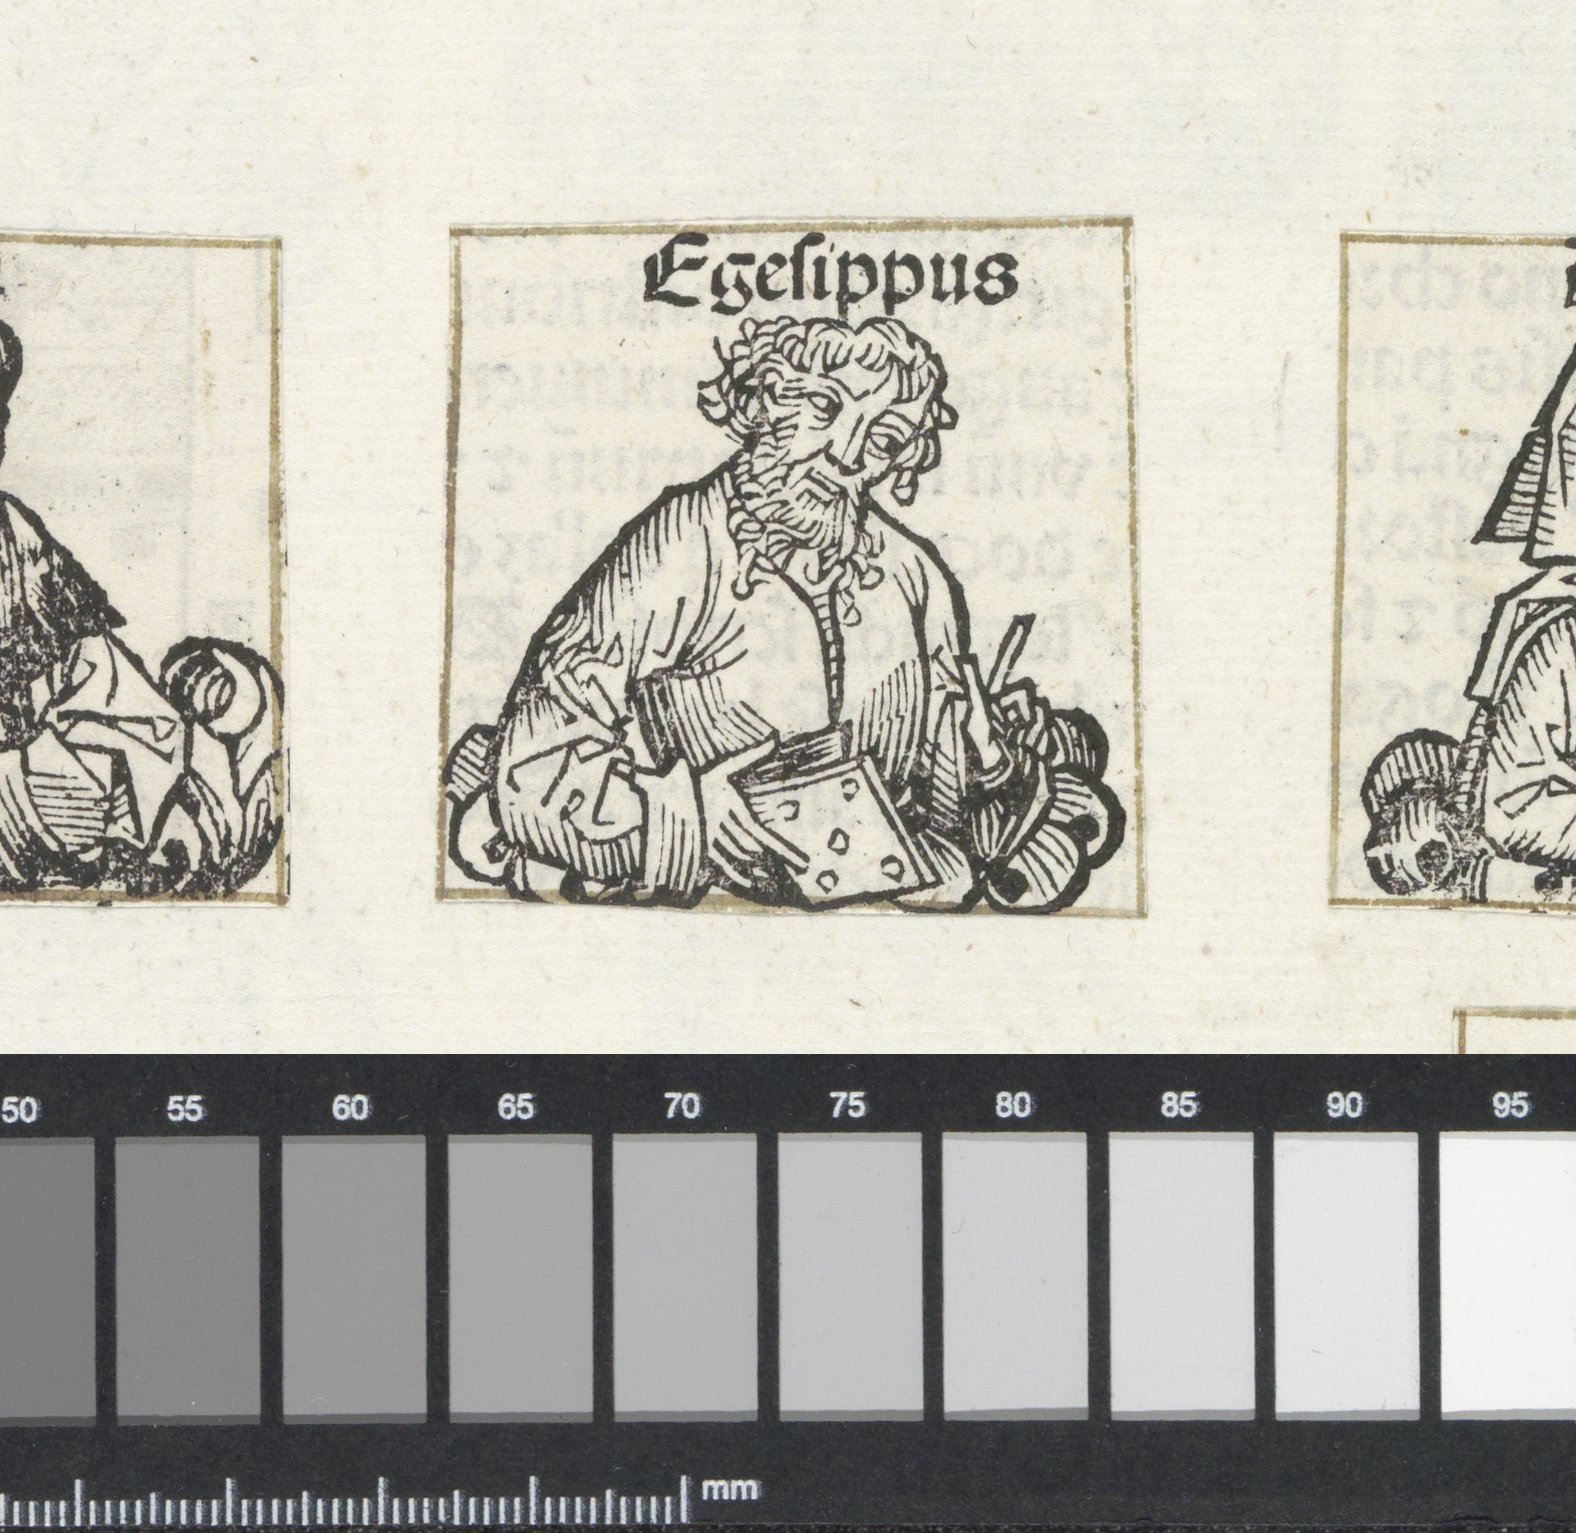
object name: print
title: Hegesippus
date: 1493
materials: paper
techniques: letterpress printing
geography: nuremberg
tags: male persons from classical history, writer, poet, author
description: De houtsnede wordt herhaaldelijk gebruikt als boekillustratie in de Liber Chronicarum (of Neurenbergkroniek) van Hartmann Schedel, verschenen in het Latijn en Duits in 1493. Zie de Latijnse uitgave, folio 111r.